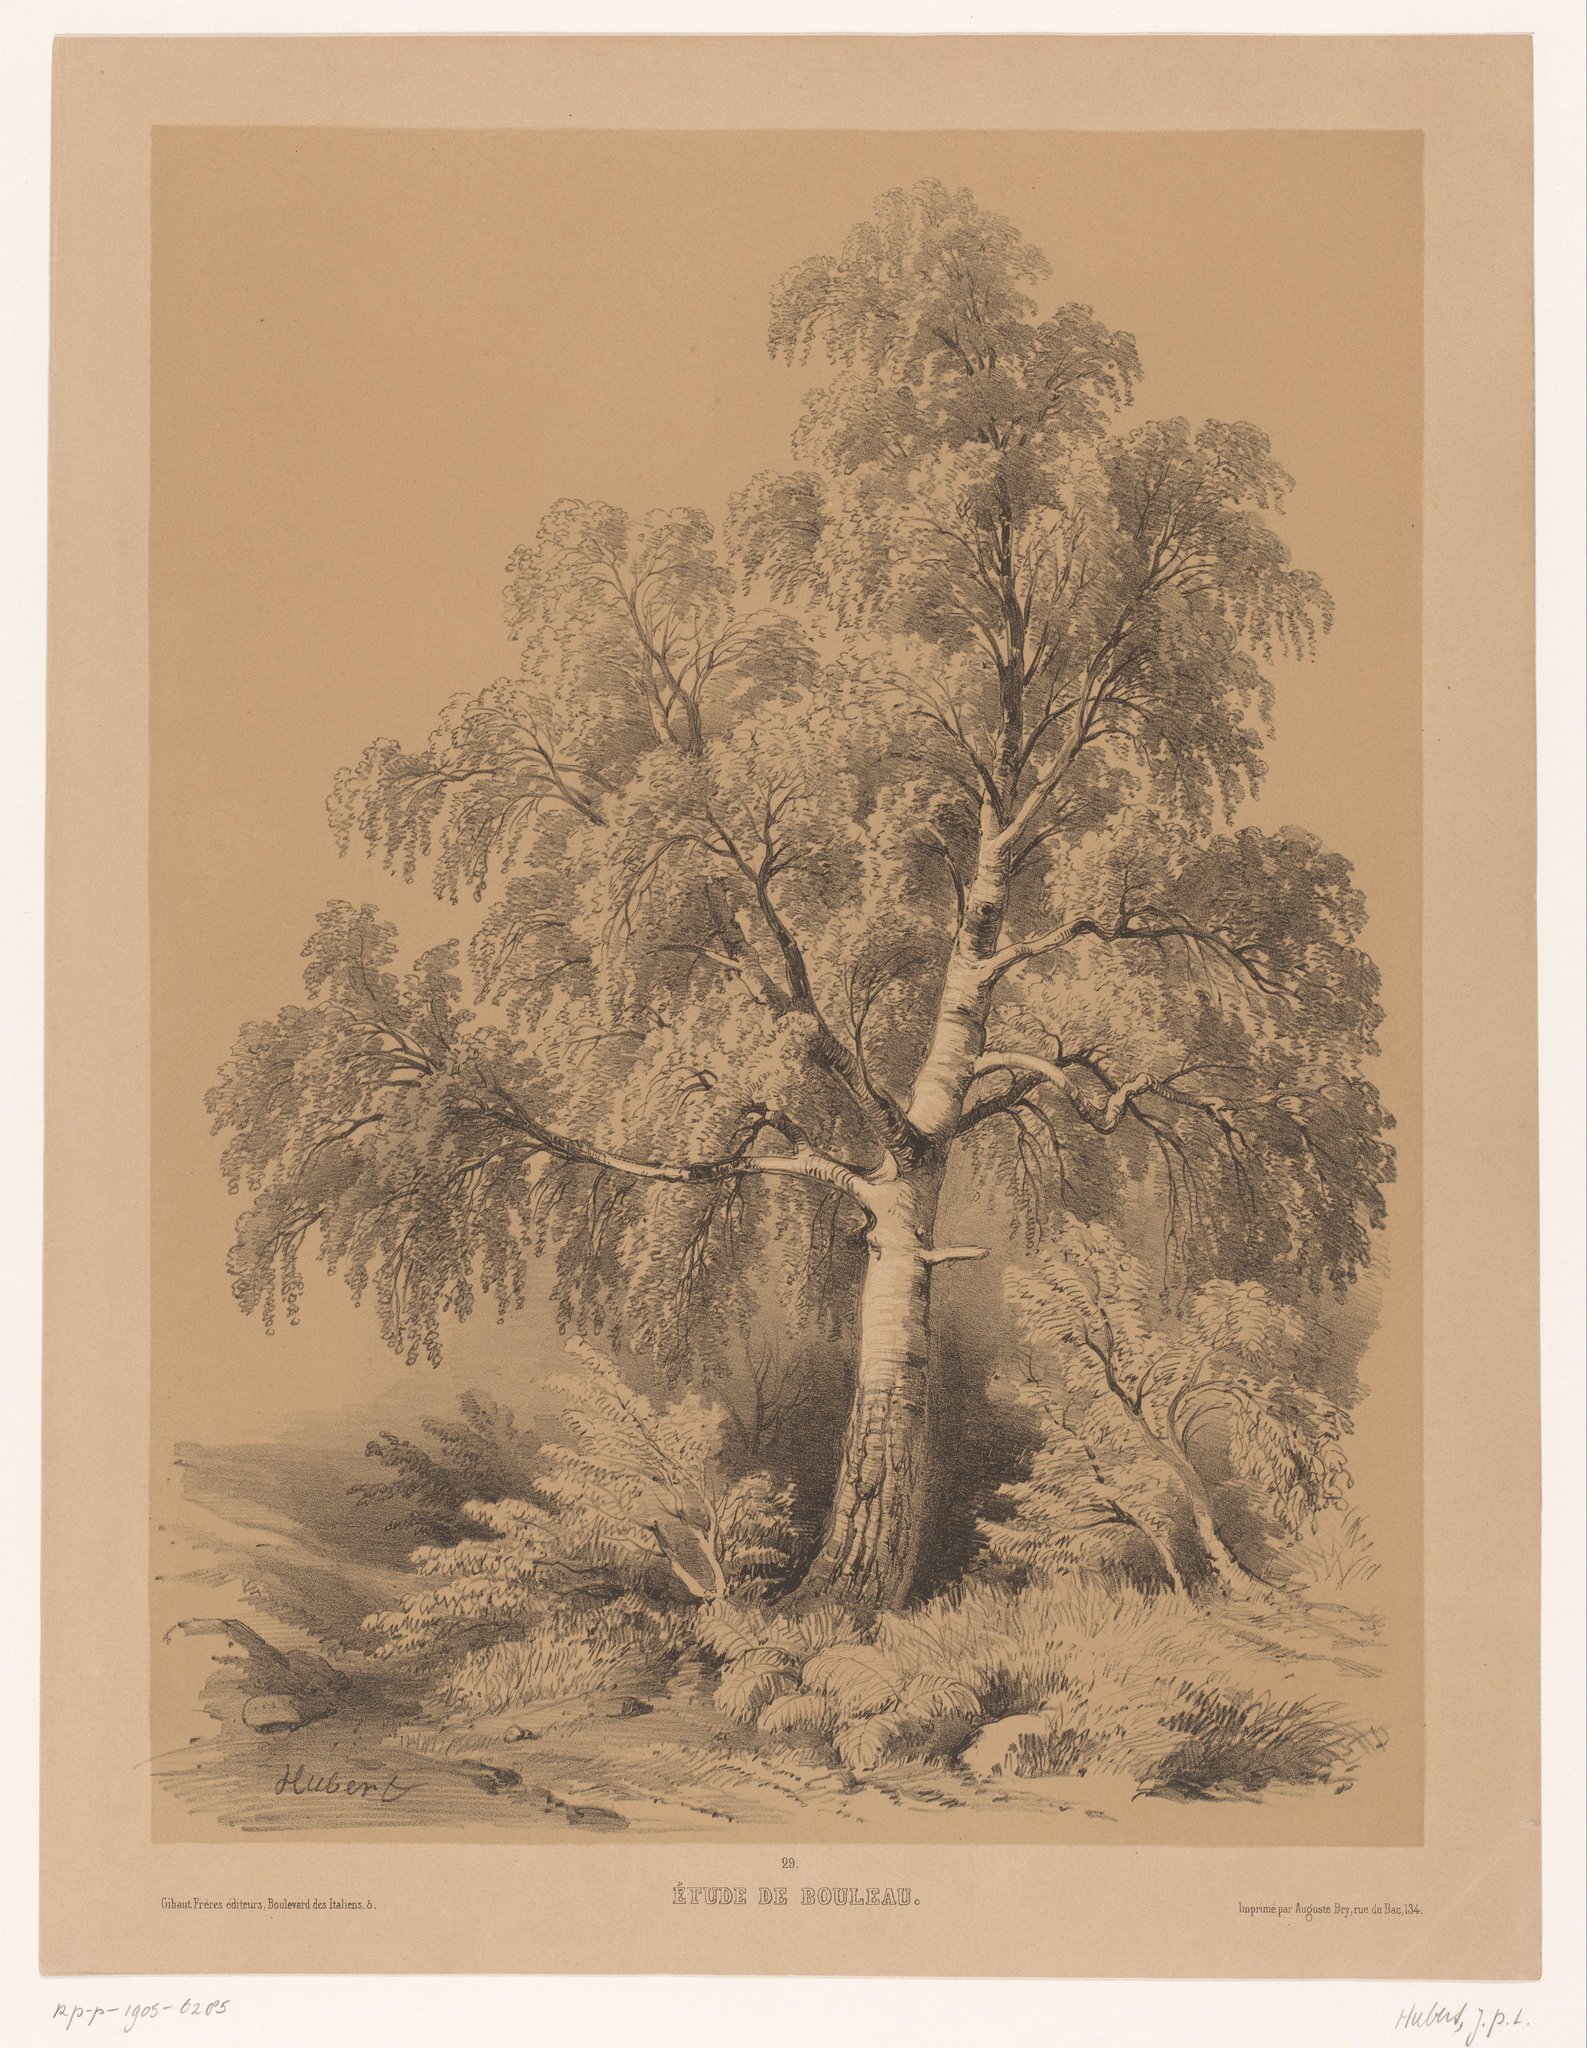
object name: print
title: Étude de Bouleau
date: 1846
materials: paper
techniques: tone lithography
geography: paris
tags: trees: birch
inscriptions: collector's mark: Lugt 2228a